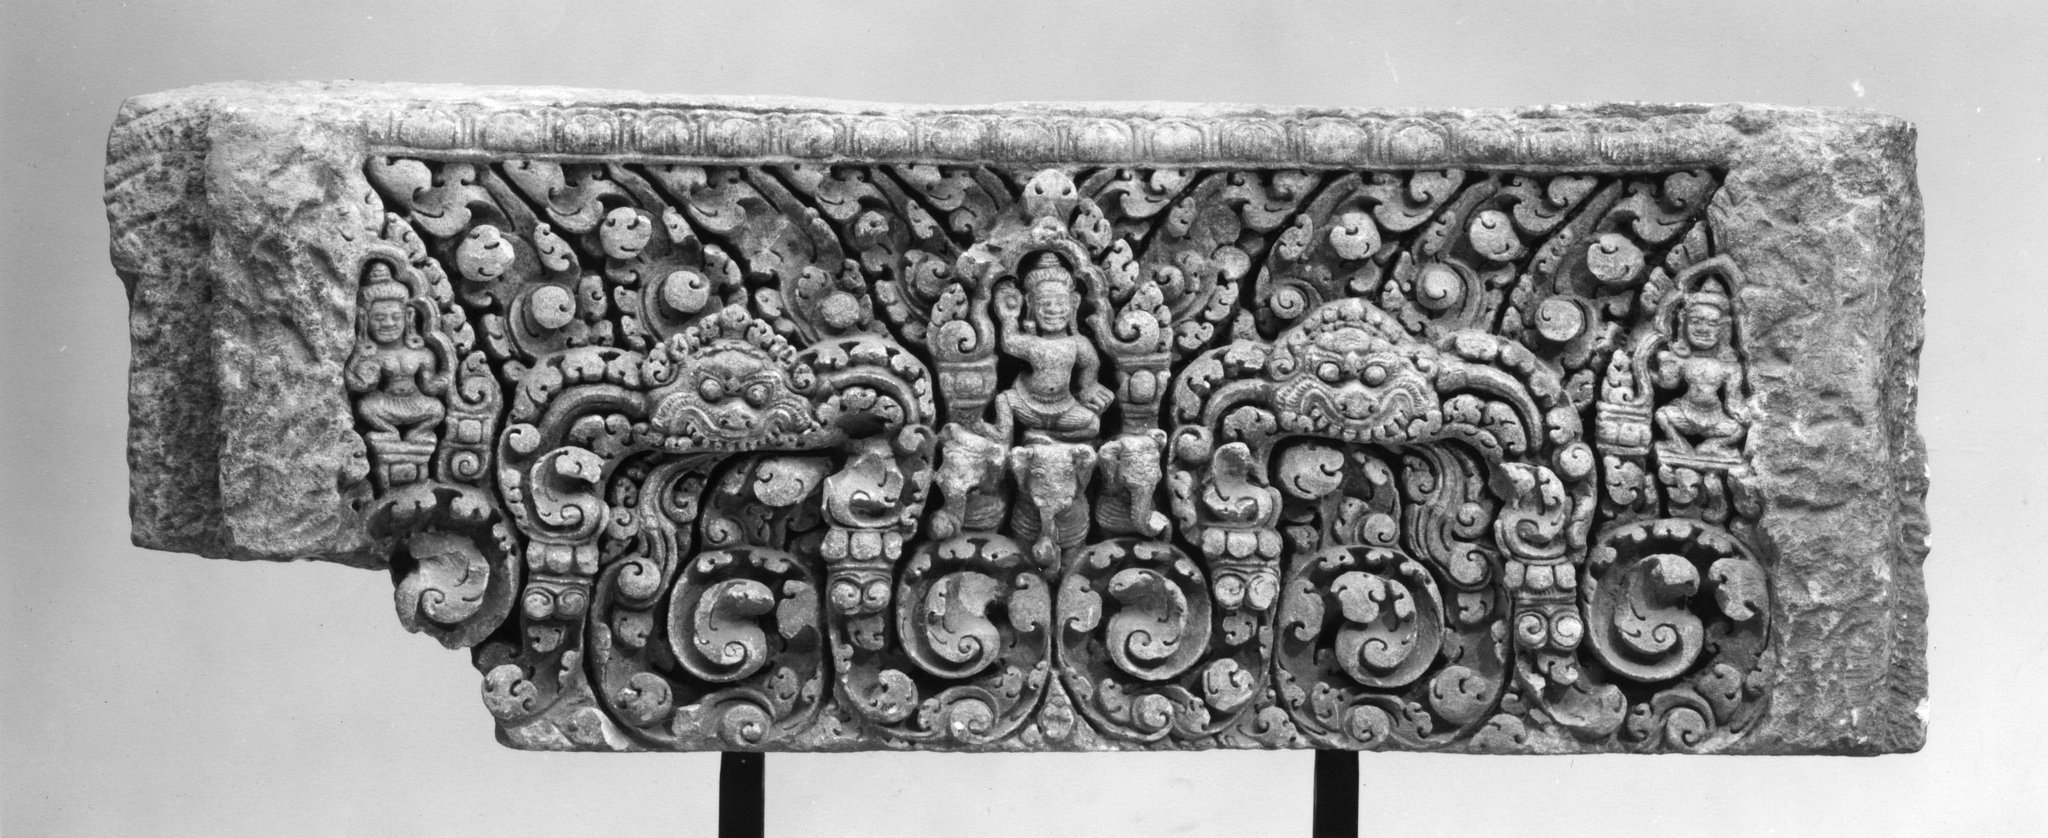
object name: lintel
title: Lintel with Indra and Two Attendants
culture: thai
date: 1001-1200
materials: stone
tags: gods,hinduism